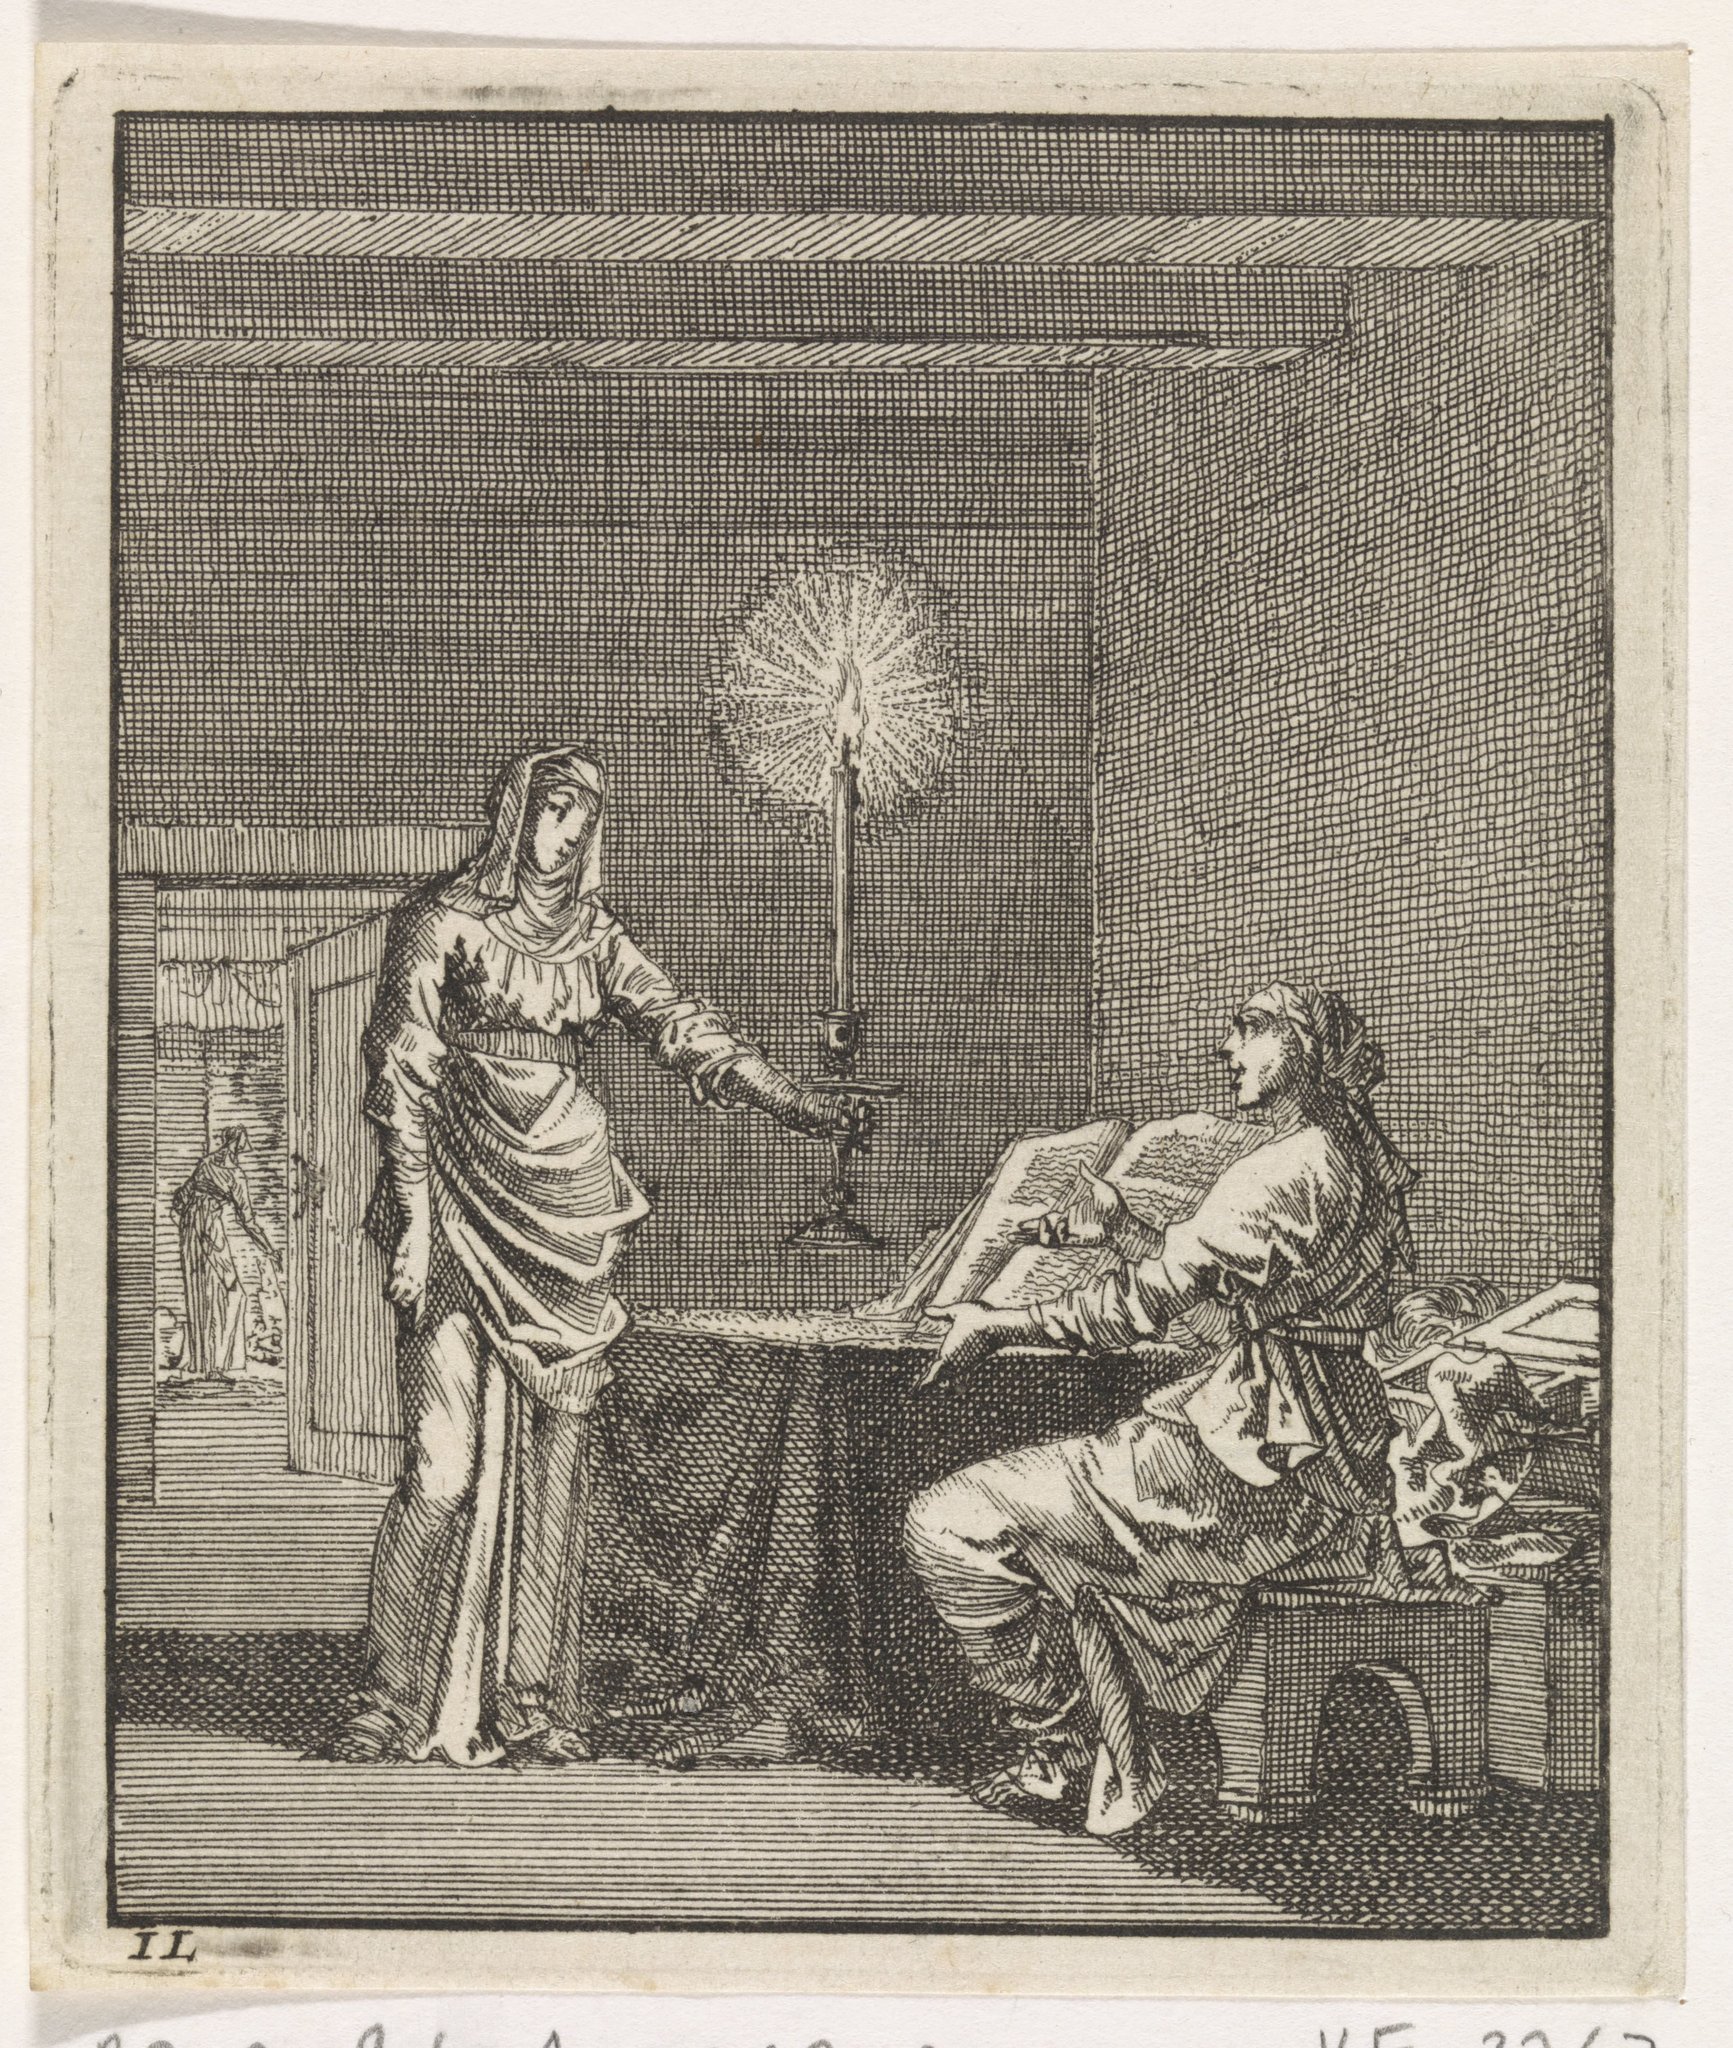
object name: book illustration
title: Vrouw licht een lezende vrouw in een donker vertrek met een kaars bij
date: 1704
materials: paper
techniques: etching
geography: amsterdam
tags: reading, candle, darkness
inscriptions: collector's mark: Lugt 2228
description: Illustratie uit: Luyken, Jan. De zedelyke en stichtelyke gezangen. Amsterdam: Wed. Pieter Arentsz (II) en Cornelis van der Sys, 1704, p. 100.